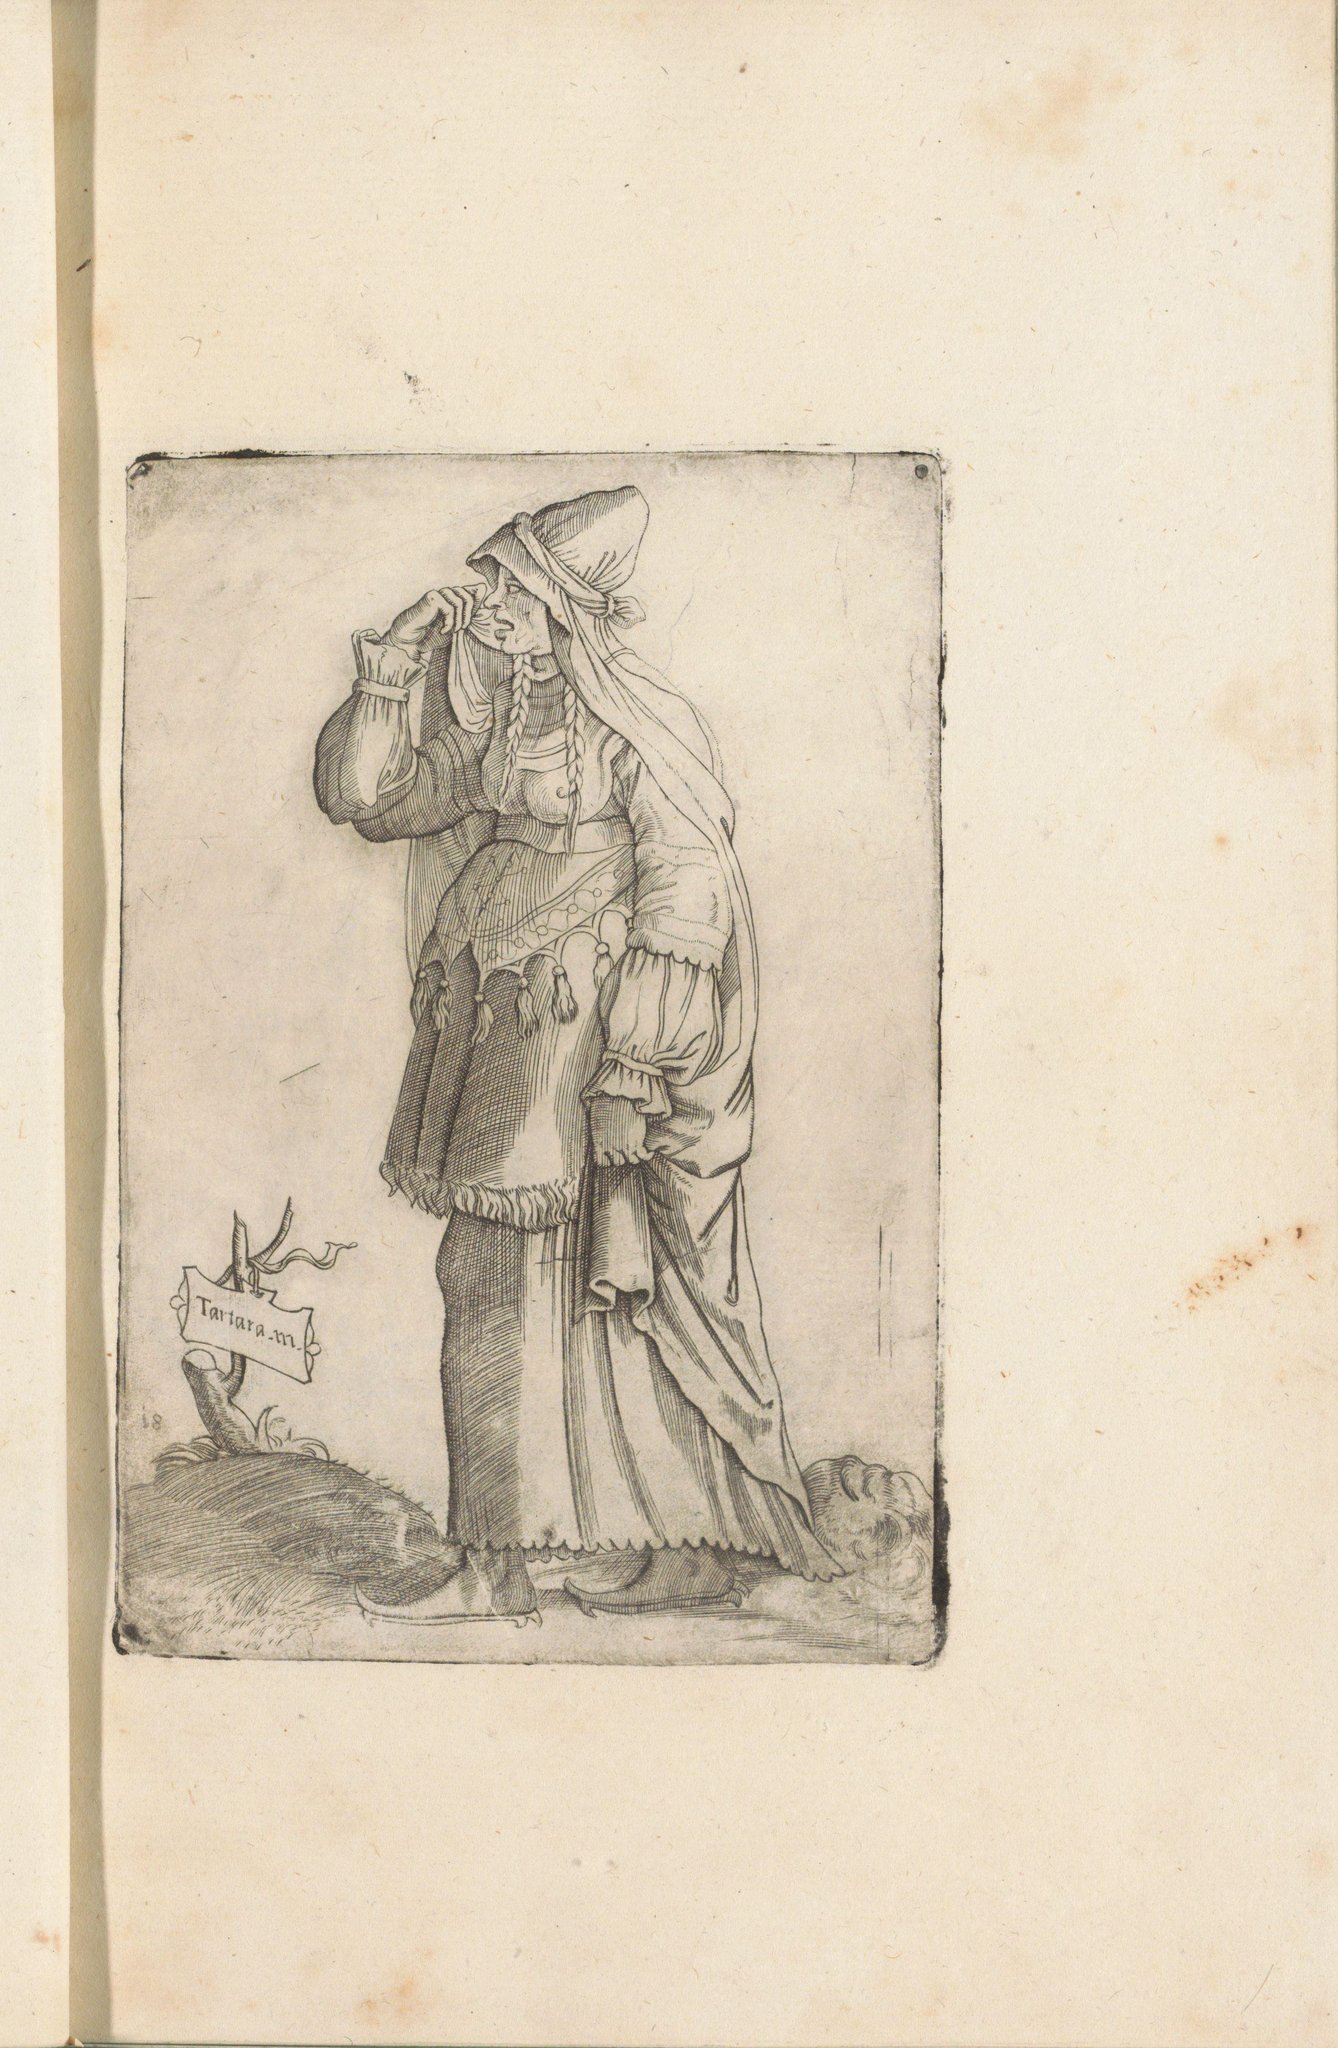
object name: costume print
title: Tartaarse vrouw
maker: ferando bertelli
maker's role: print maker, publisher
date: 1569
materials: paper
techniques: engraving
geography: venice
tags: fashion plates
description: Tartaarse vrouw, lopend naar links, slip van de sluier in de linkerhand. Onderdeel van het kostuumboek getiteld 'Omnium fere gentium nostrae aetatis habitus, nunquam ante hac aediti', Venetië 1569. Heruitgave uit 1569 van de eerste editie uit 1563.